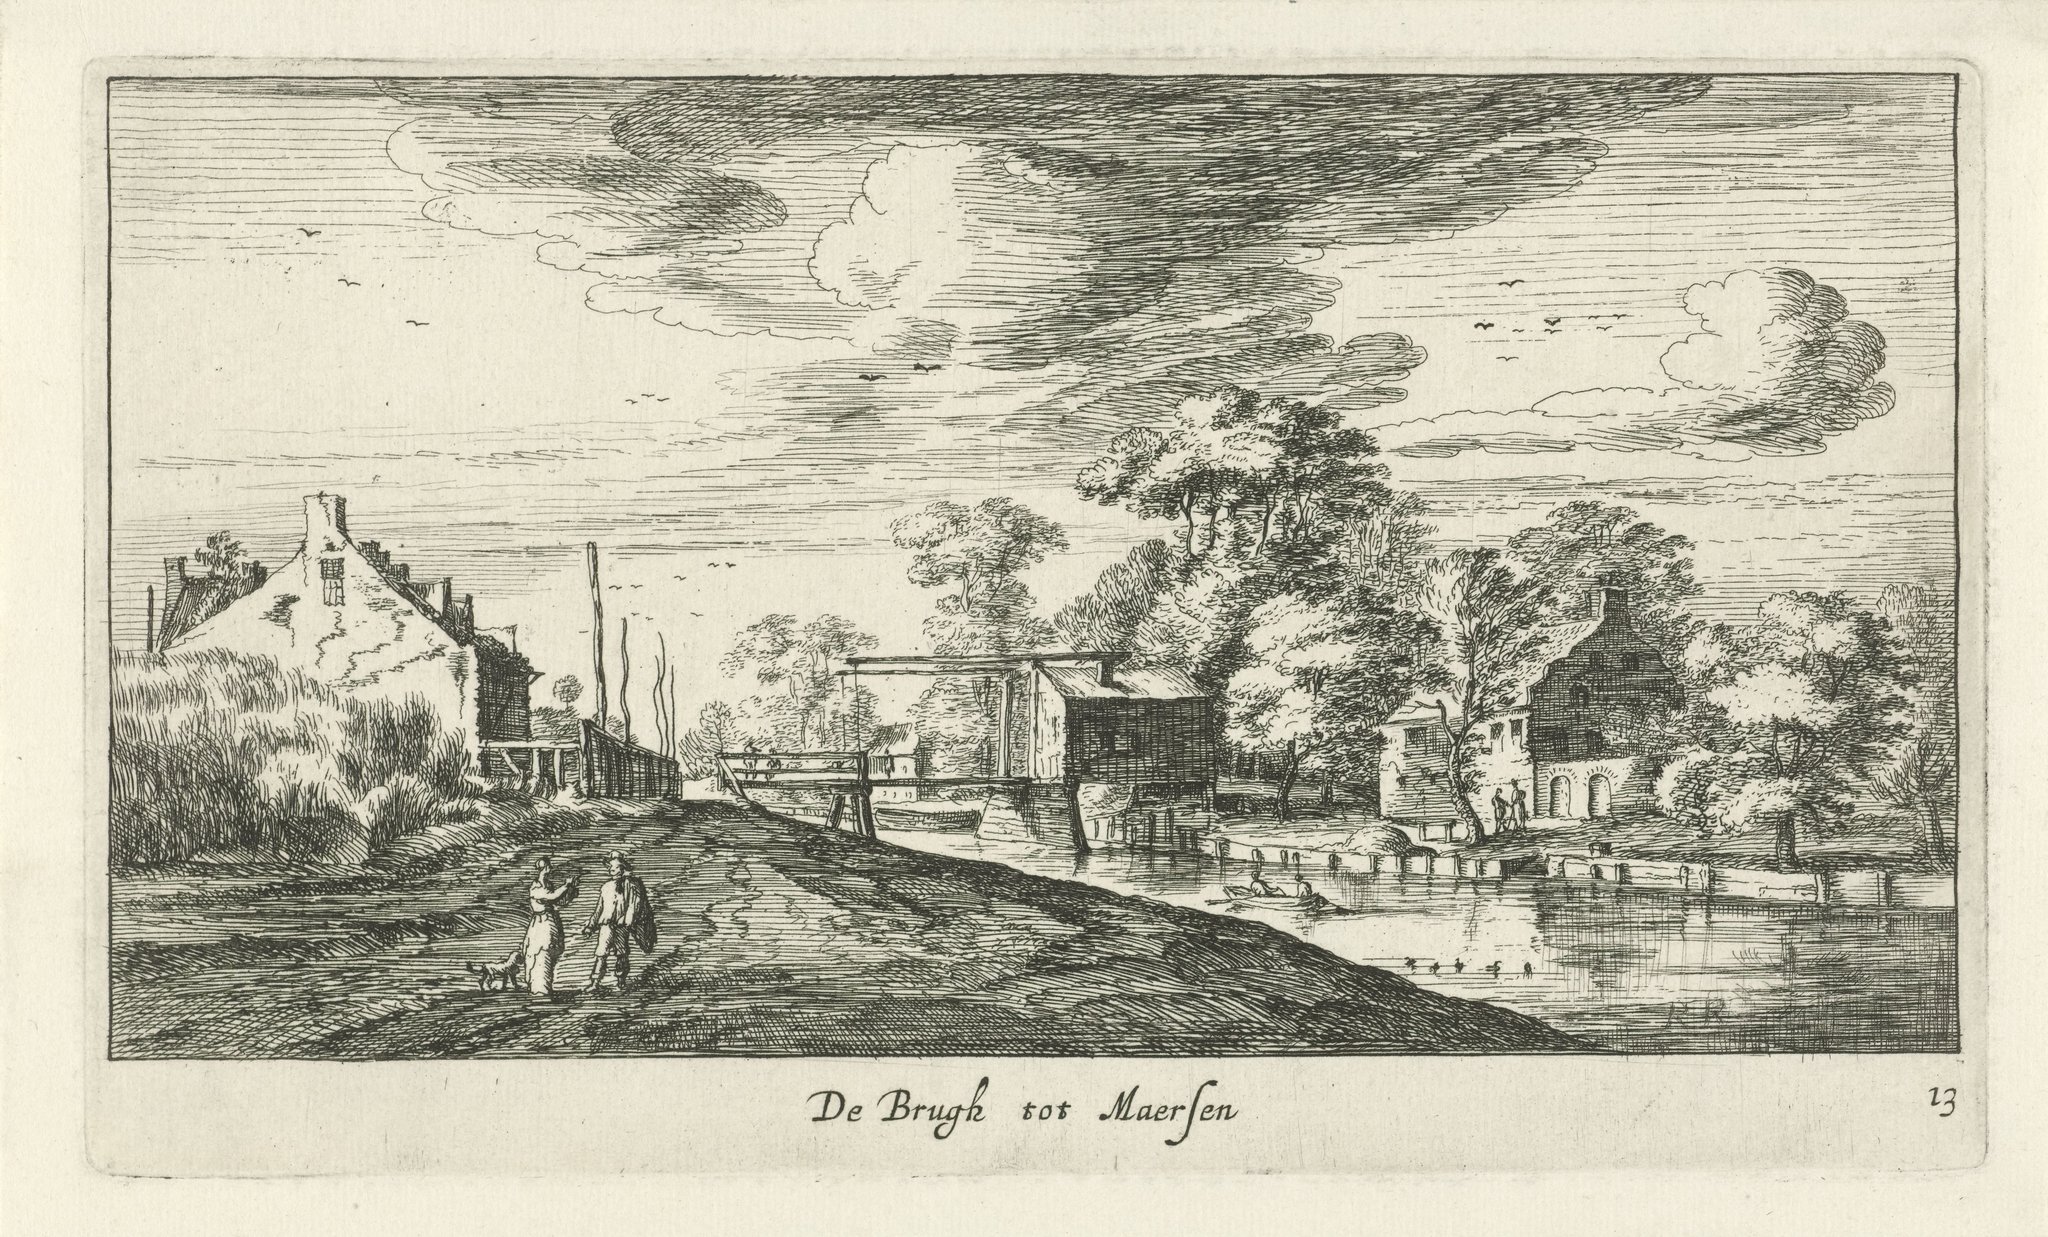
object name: print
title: Plaisante Lantschappen ofte vermakelijcke Gesichten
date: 1637-1652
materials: paper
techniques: engraving, etching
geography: amsterdam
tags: rowing-boat, canoe, etc., bridge, maarssen, vecht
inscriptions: collector's mark: Lugt 240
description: Gezicht op een ophaalbrug bij Maarssen met rechts de rivier de Vecht. De prent is deel van een serie landschappen met dorpen rondom Amsterdam.